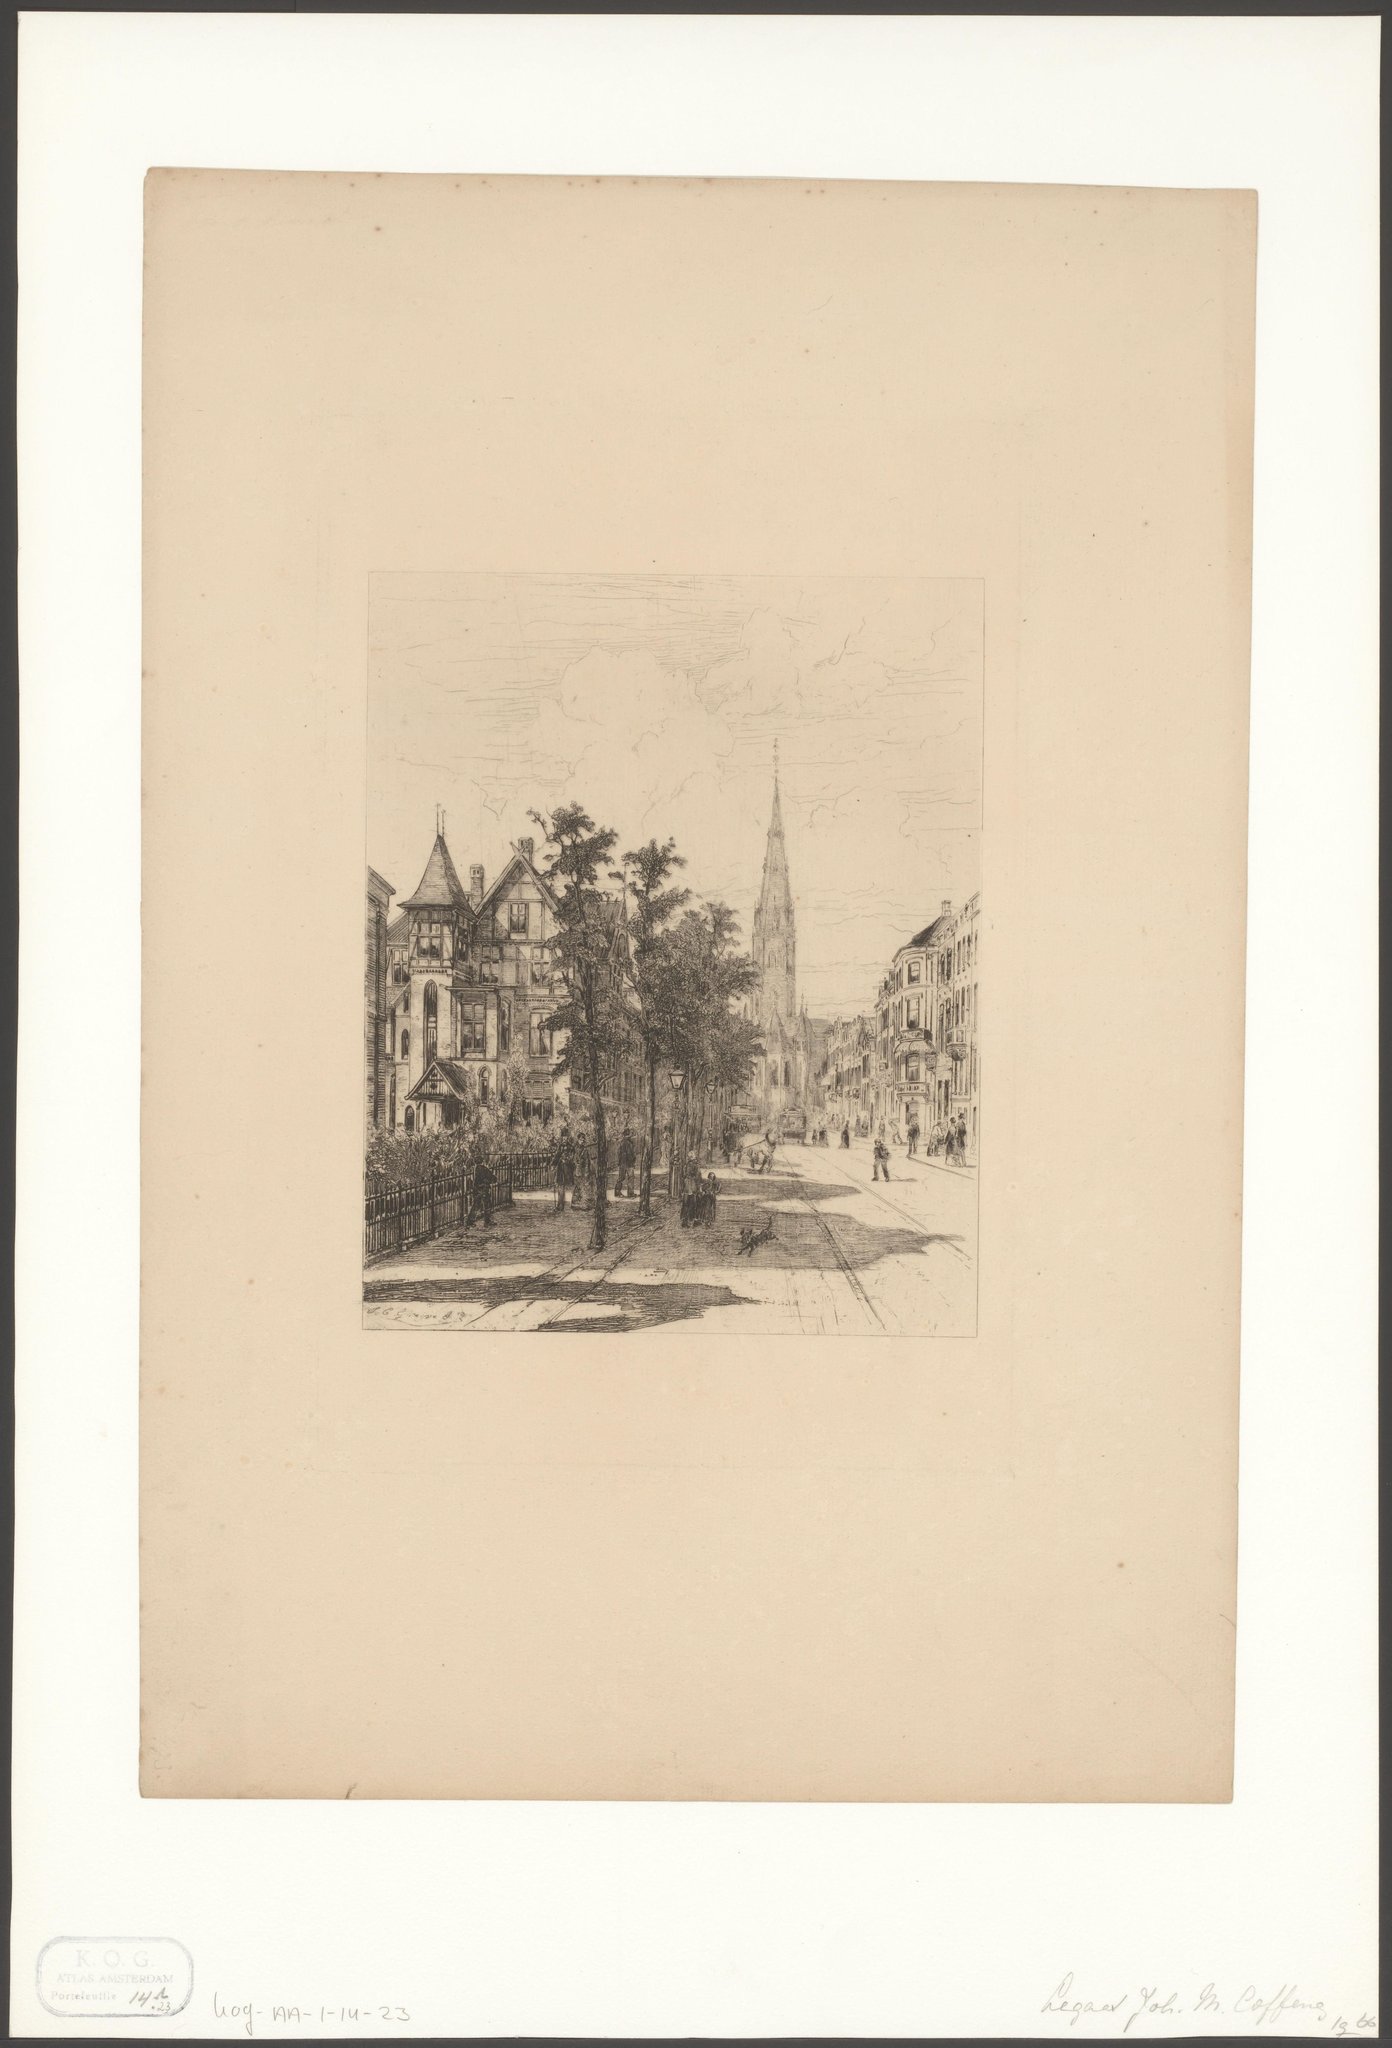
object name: print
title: Gezicht op de Vondelstraat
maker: johan conrad greive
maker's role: draughtsman, painter, print maker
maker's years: 1837-1891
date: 1882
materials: paper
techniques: aquatint, etching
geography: amsterdam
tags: tramway, tram, city-view in general; 'veduta', church (exterior), the usual house or row of houses, street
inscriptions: collector's mark: ‘14A.23’ Lugt 1641b, inscription: ‘Legaat Joh. M. Coffeng / 1966’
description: Onderwerpsrubriek binnen de Atlas Amsterdam: Verhulststraat (Johannes), Viaducten, Vierwindenstraat, Vinkenbuurt, Vinkenpad, Vinkenstraat, Vischsteeg, Vliegendesteeg, Voetboogstraat, Volewijk, Vondelstraat, Voorburgwal (N.Z.).